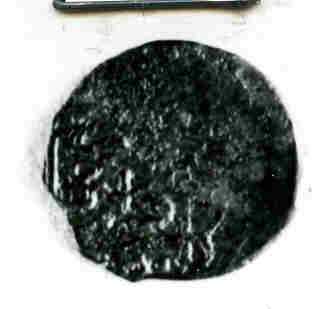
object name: coin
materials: copper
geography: iran